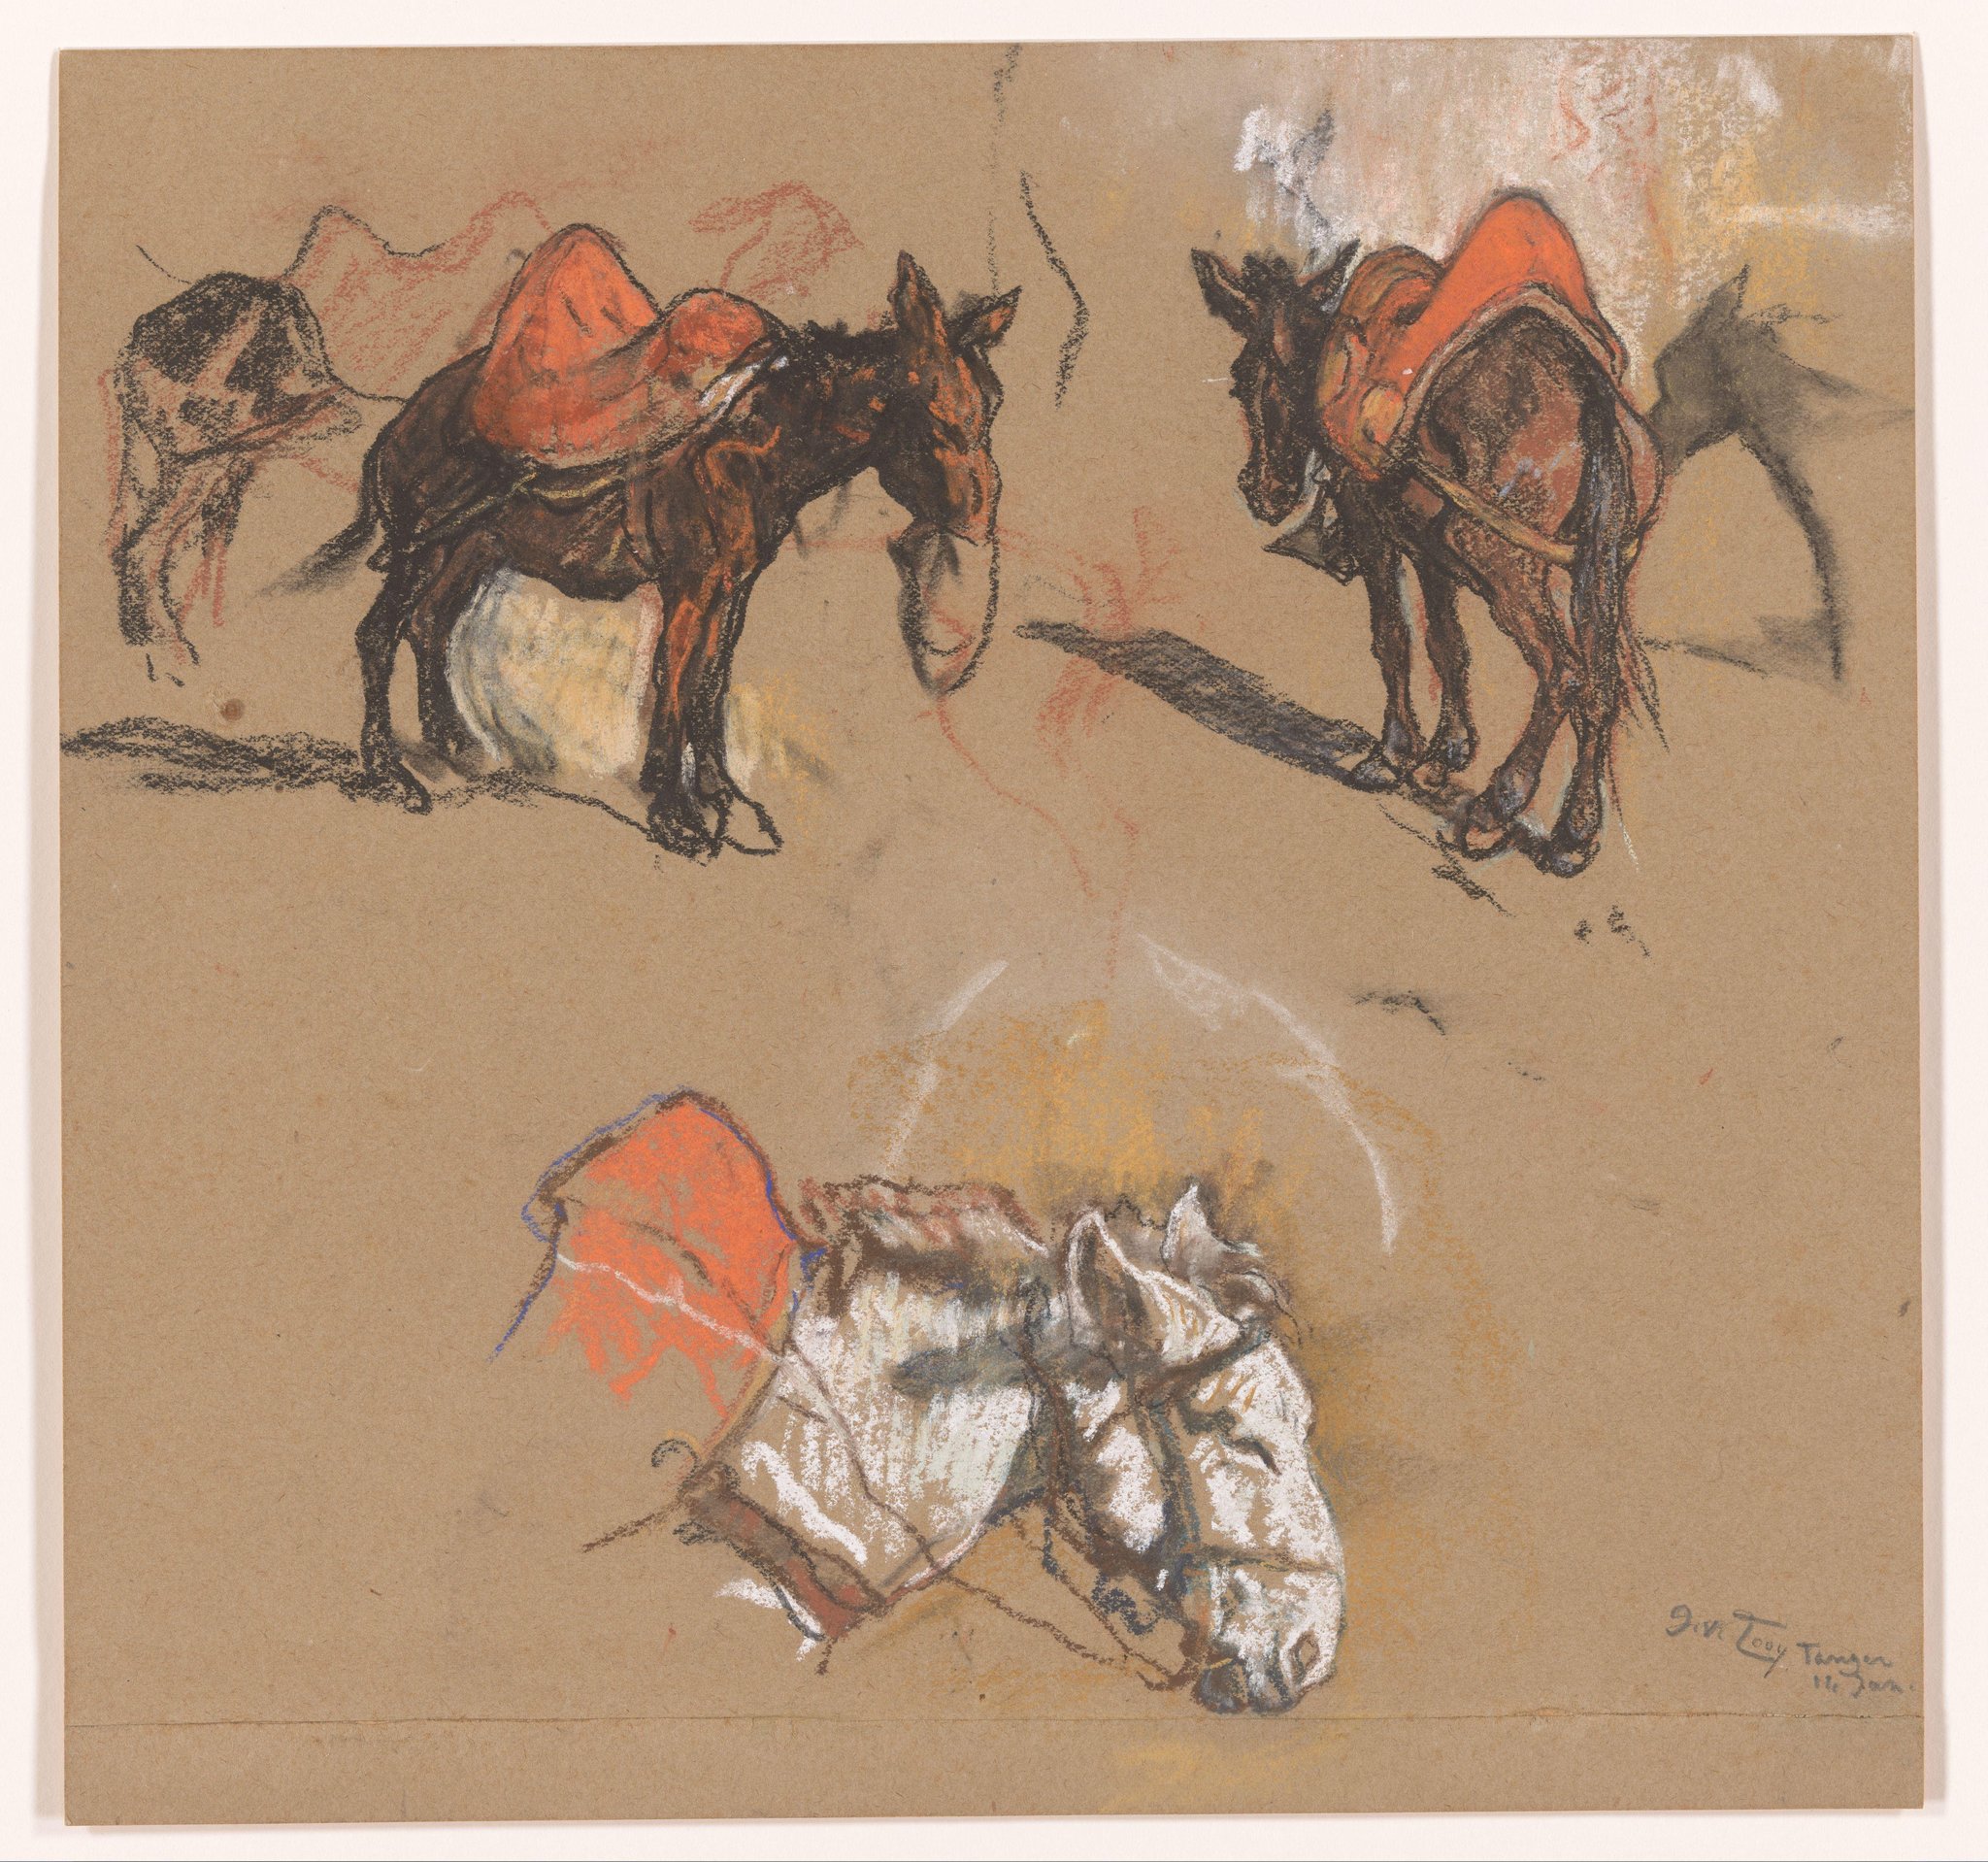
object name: drawing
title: Studies van ezels en een muildier op de Grote Markt te Tanger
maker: jac van looij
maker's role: draughtsman, painter, print maker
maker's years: 1855-1930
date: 1902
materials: chalk, paper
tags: ass, donkey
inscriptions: signature, date and inscription: ‘J.v. Looy Tanger 14 jan’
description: De huidige titel is door het Rijksmuseum overgenomen van het Instituut Collectie Nederland.